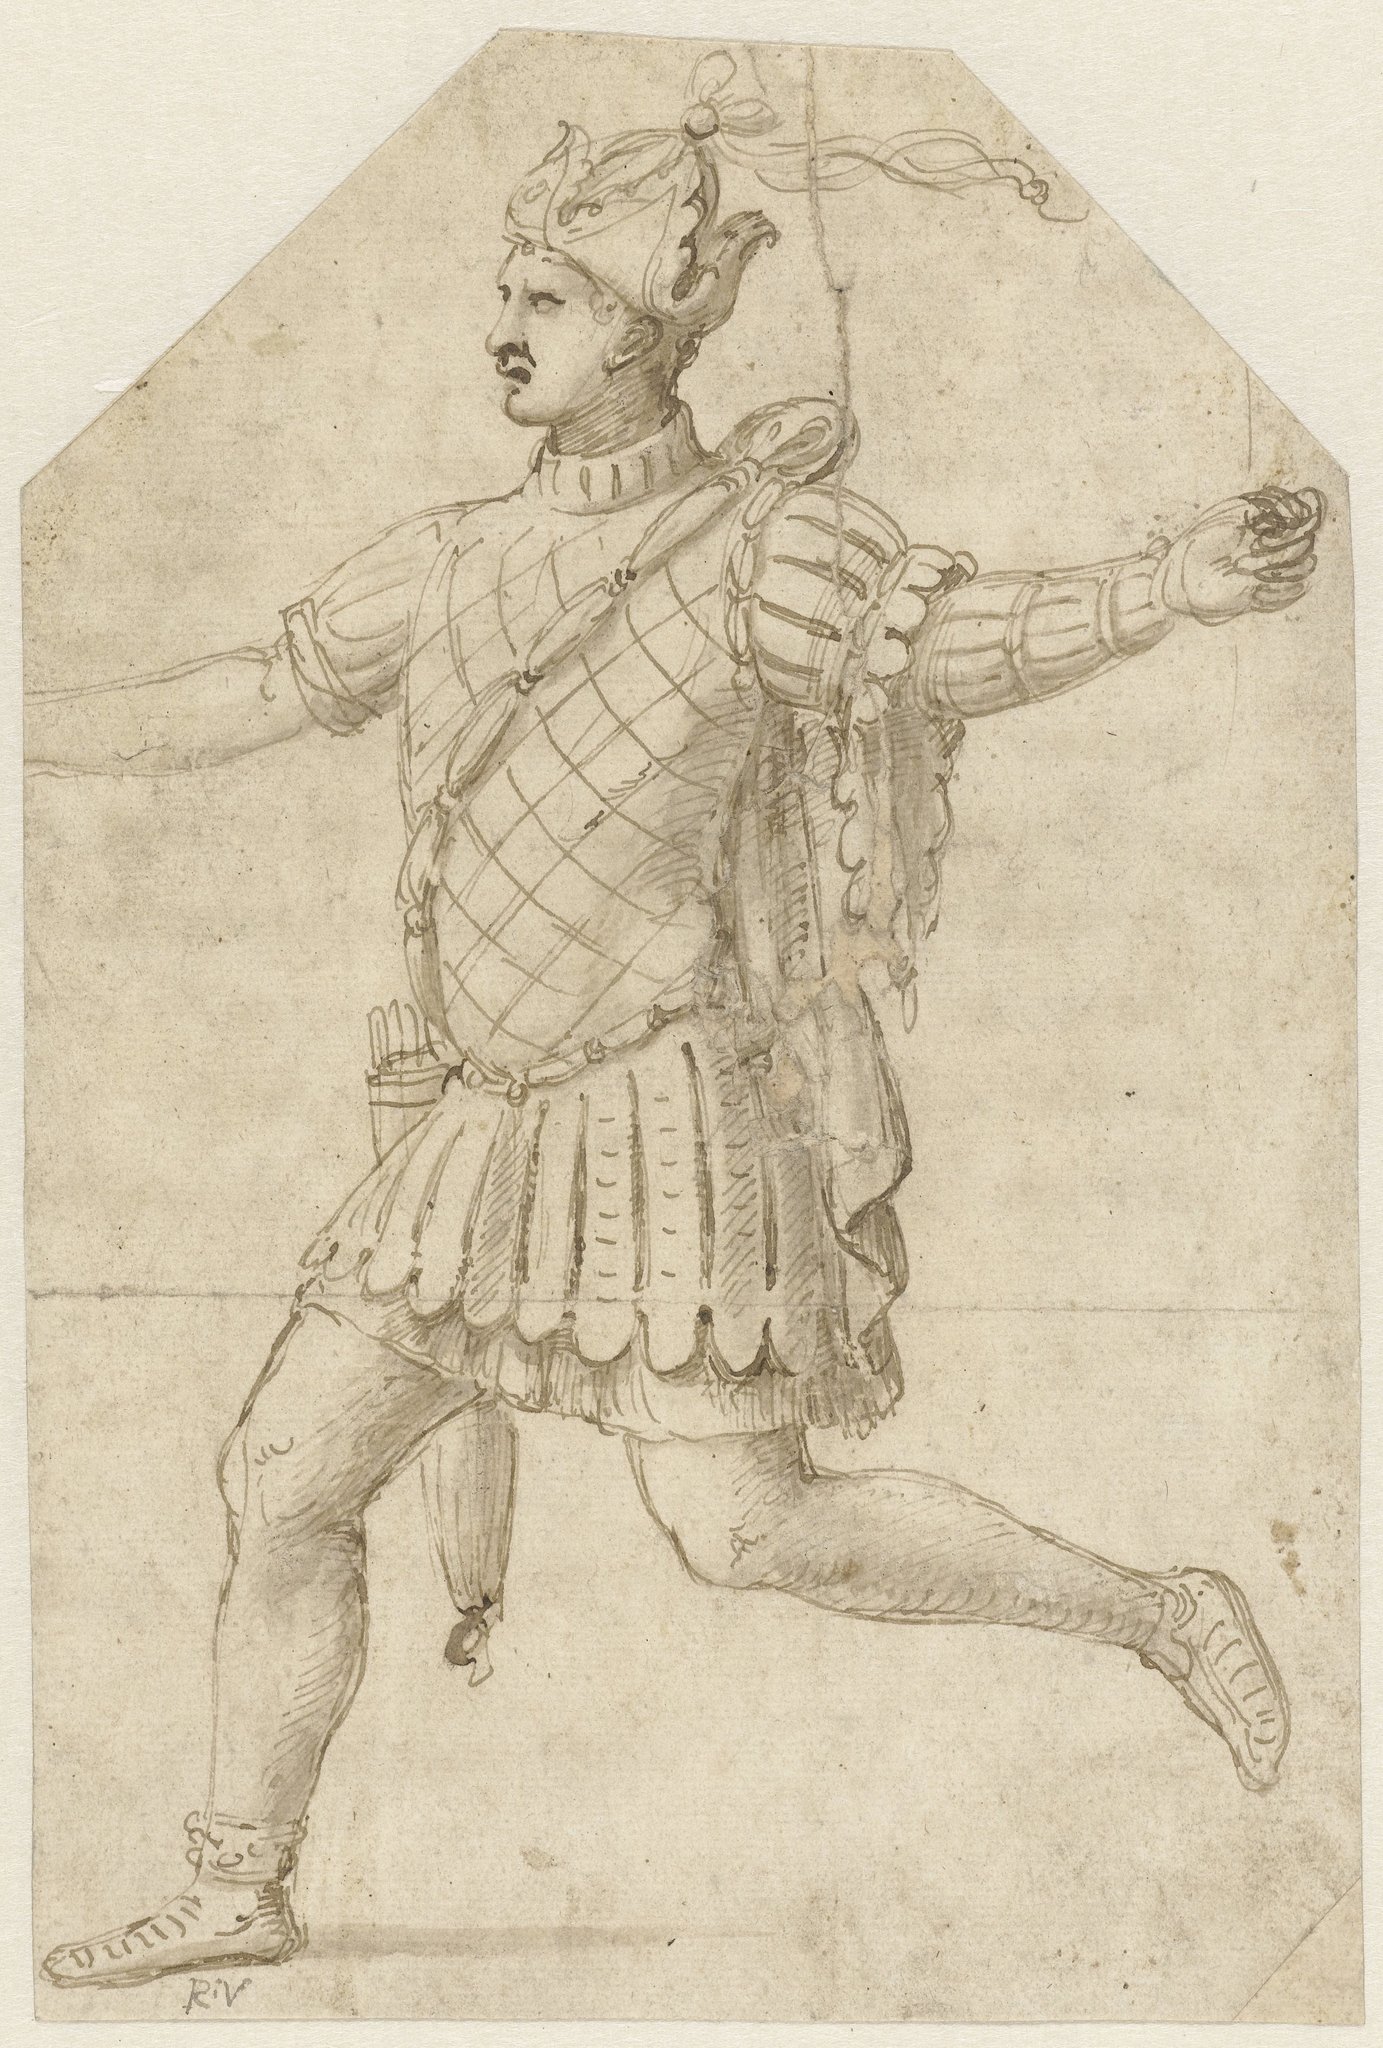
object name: drawing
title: Paardenknecht met pijlenkoker aan een bandelier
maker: giulio romano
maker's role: draughtsman, painter, print maker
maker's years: 1499-1546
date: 1510-1546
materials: ink, paper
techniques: brush, pen